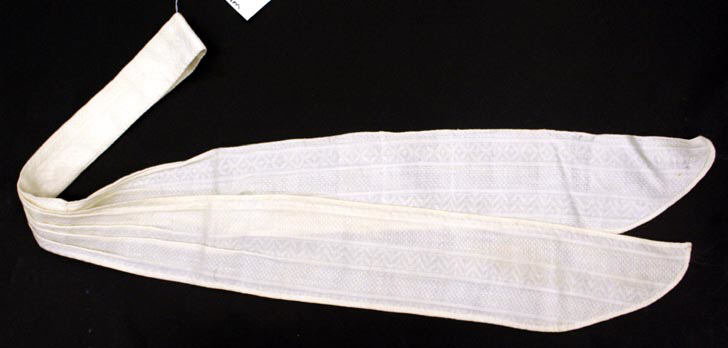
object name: neckcloth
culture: european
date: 1830-1839